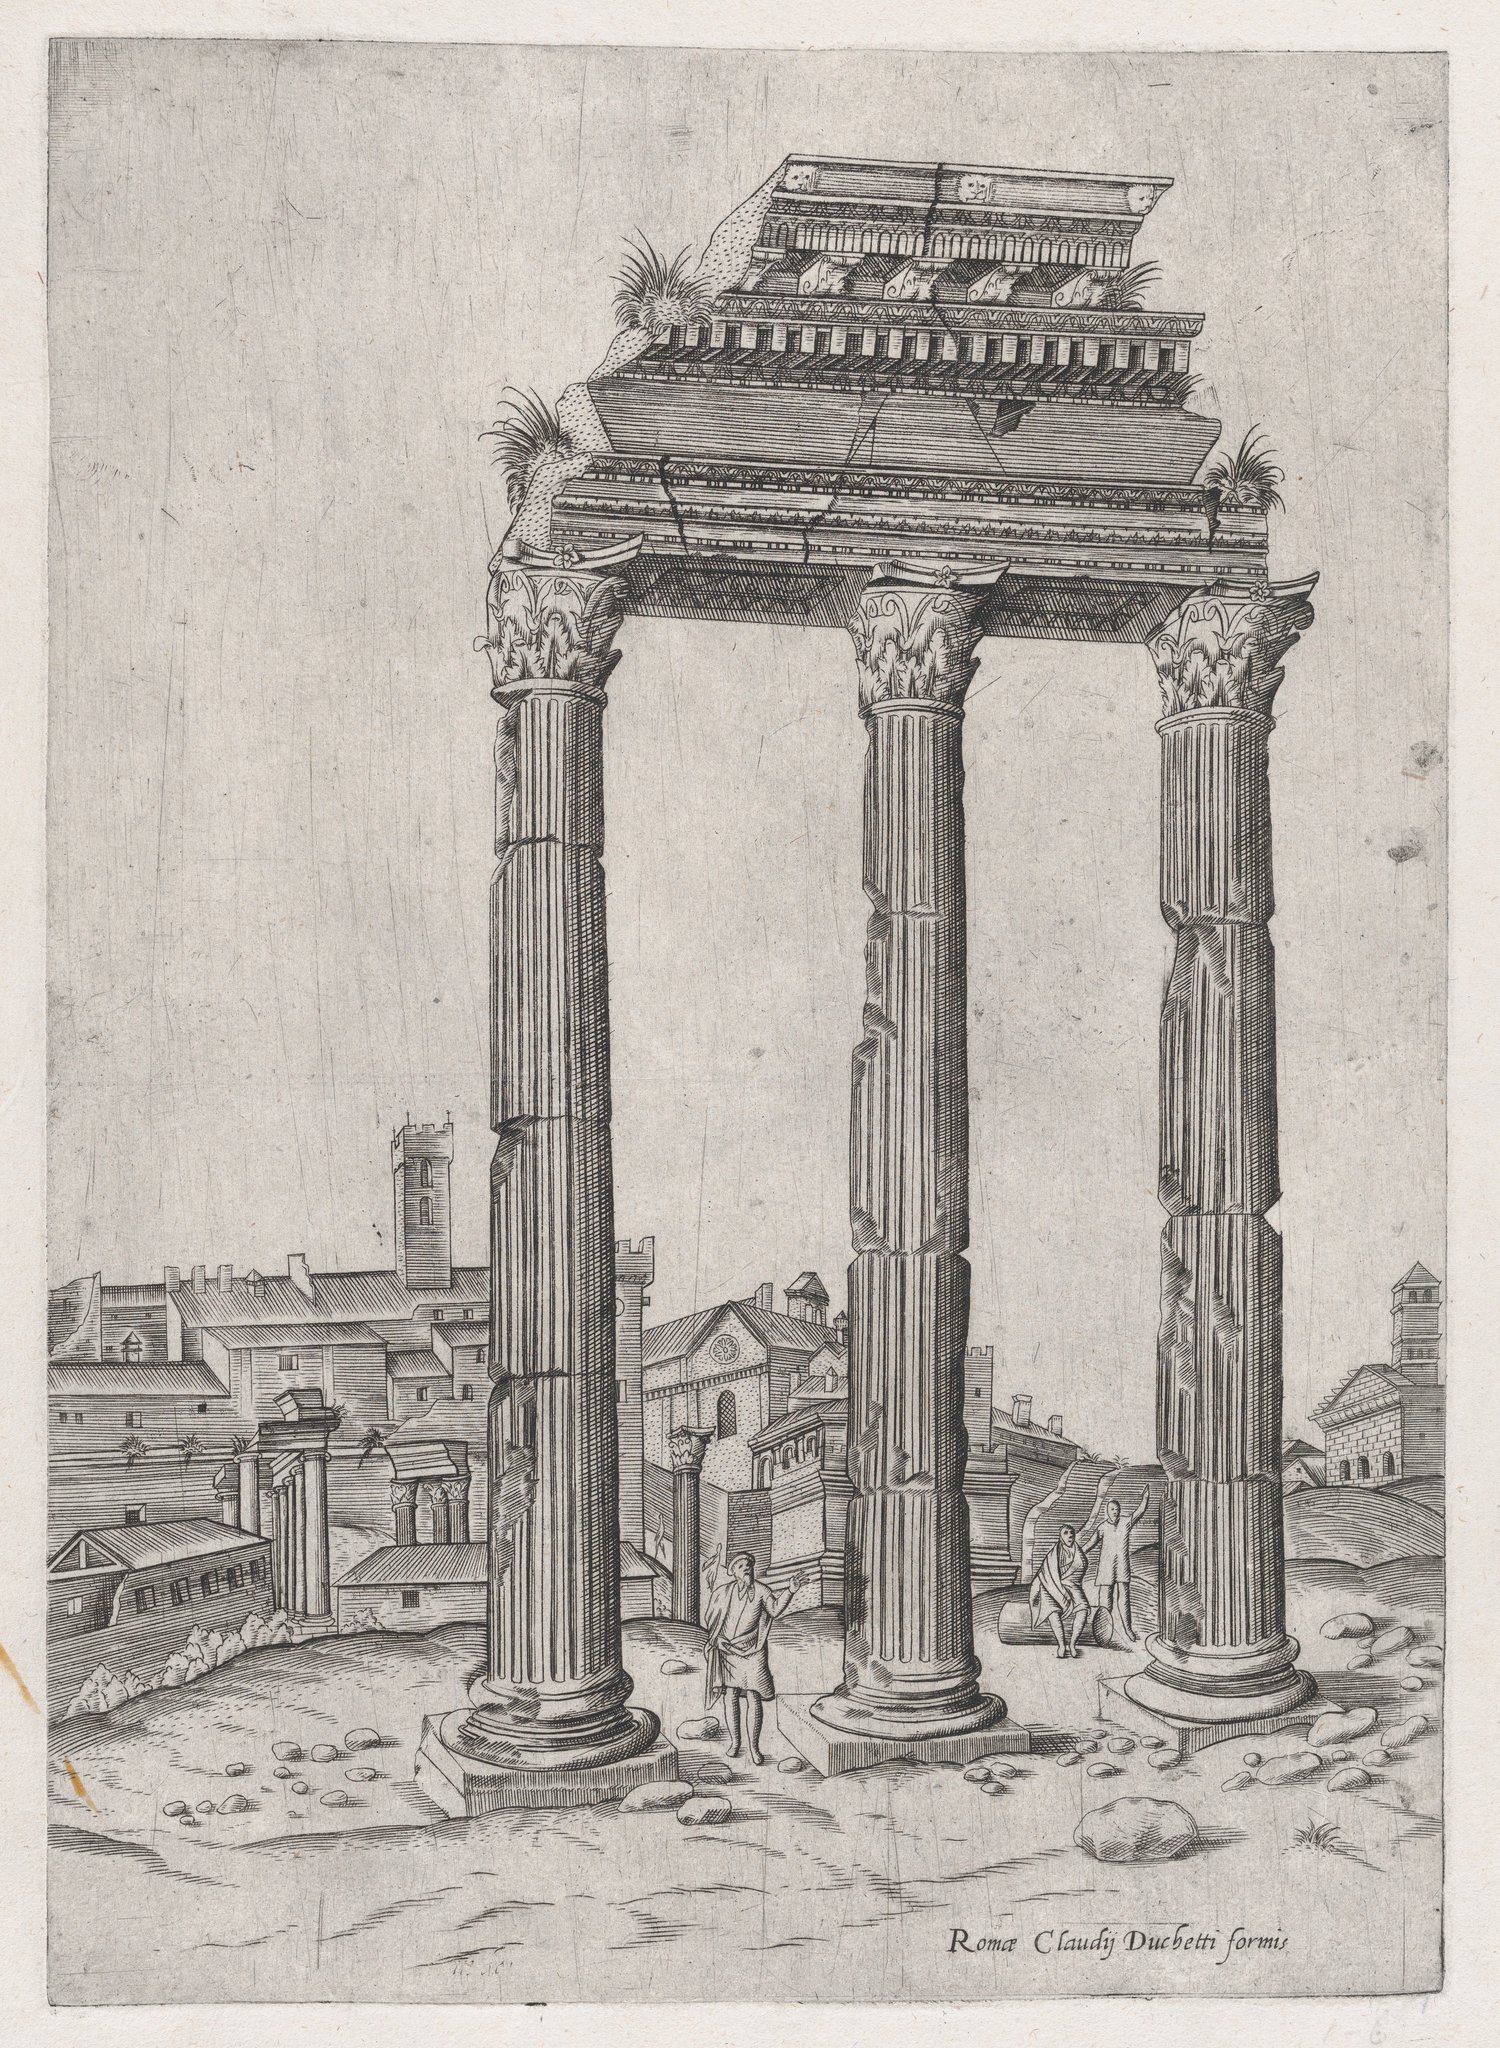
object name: print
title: Portico of the Temple of Julius, from "Speculum Romanae Magnificentiae"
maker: Anonymous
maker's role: artist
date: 1501-1600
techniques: engraving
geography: rome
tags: columns,ruins,rome